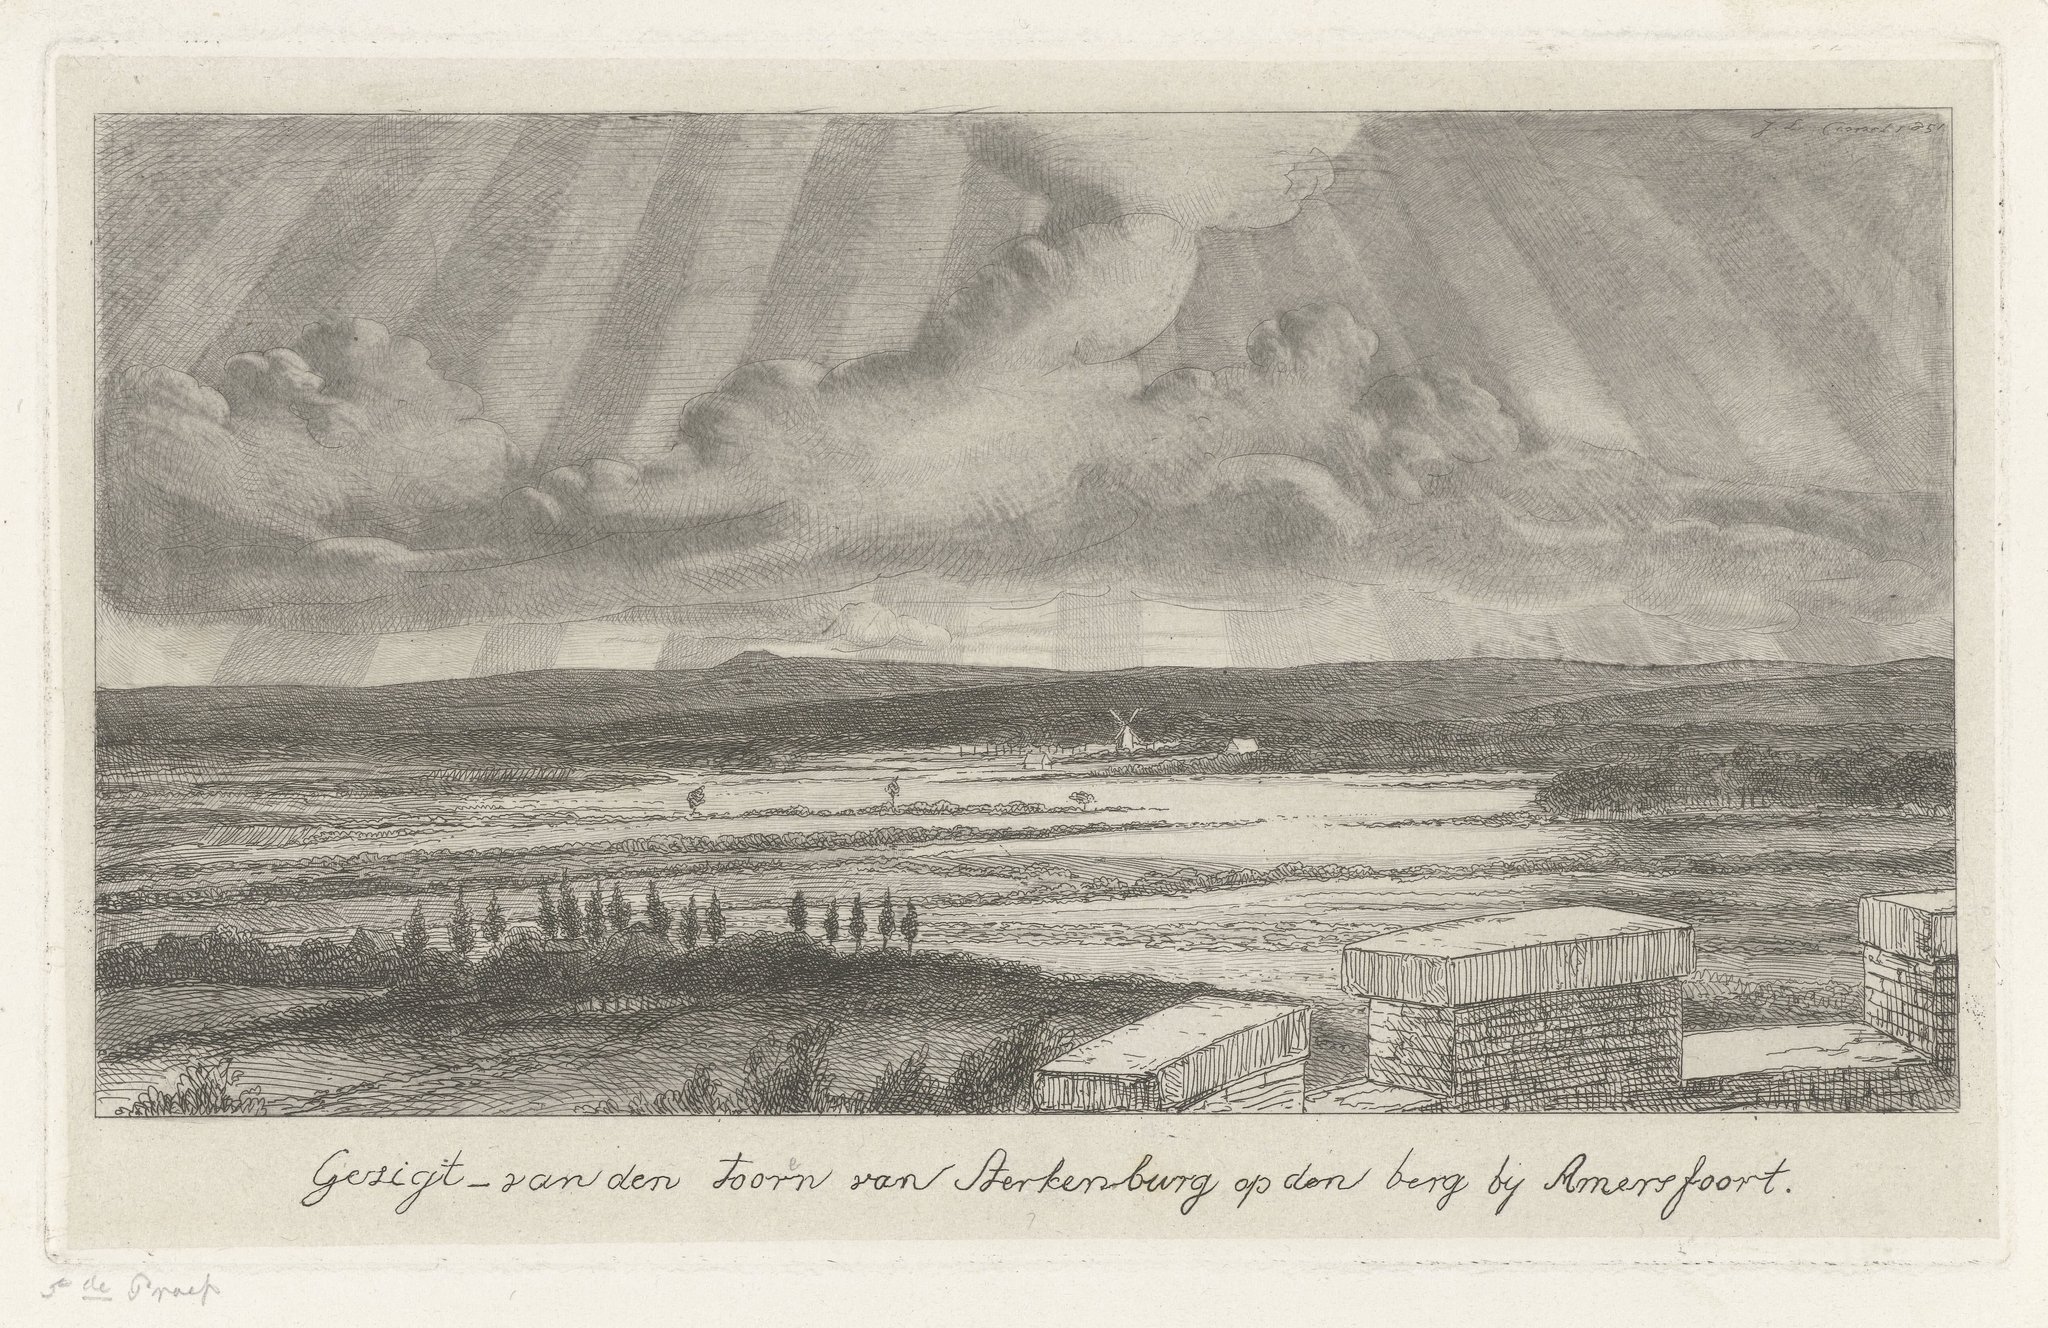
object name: print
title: Gezigt van den toorn van Sterkenburg op den berg by Amersfoort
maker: jacobus ludovicus cornet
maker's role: draughtsman, print maker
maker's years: 1815-1882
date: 1851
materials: paper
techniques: etching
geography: leiden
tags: river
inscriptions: collector's mark: Lugt 2166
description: Gezicht op het landschap rond Amersfoort, gezien van op de toren van Ridderhofstad Sterkenburg. Op de voorgrond rechts de kantelen van het kasteel. Donkere wolken verschuilen de zon.